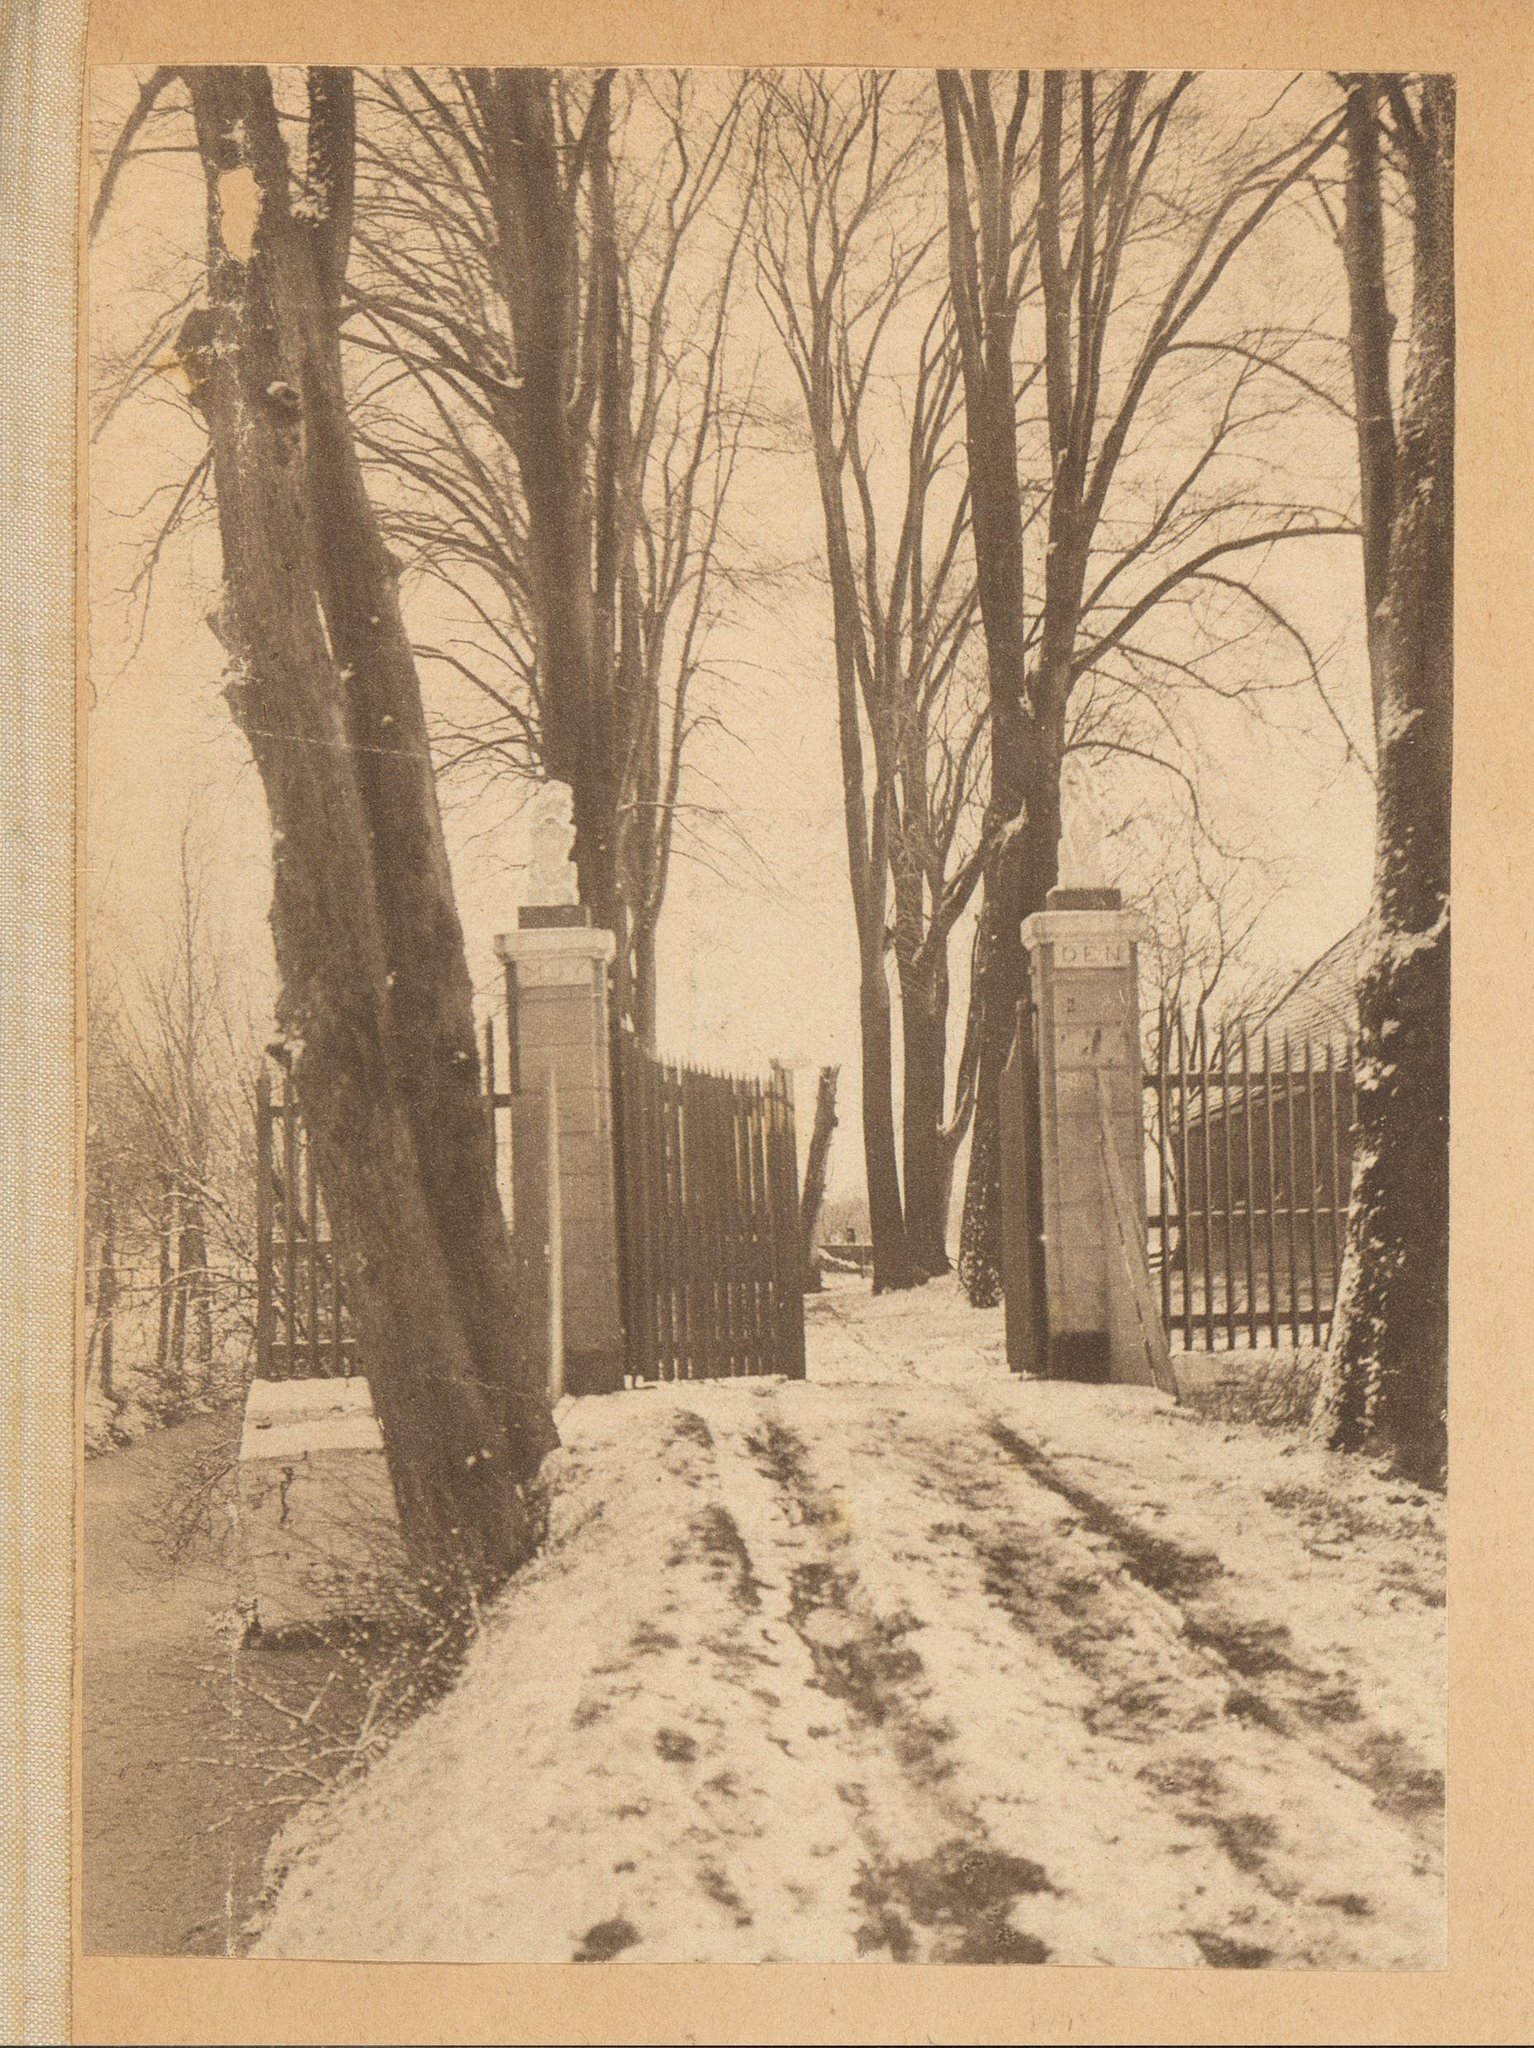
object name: photograph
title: Toegangshek van hoeve Muyden te Rotterdam in de sneeuw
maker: Anonymous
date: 1900-1920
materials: paper, ink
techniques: rotogravure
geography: netherlands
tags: gate, entrance, forest path or lane, snow, rotterdam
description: Toegangshek van hoeve Muyden, gelegen aan het Toepad te Rotterdam. De hoeve is in 1959 gesloopt. Het toegangshek staat tegenwoordig in de tuin van Museum Booijmans van Beuningen in Rotterdam. Onderdeel van Familiealbum met foto's van een familie in de voormalige kolonie Nederlands-Indië en van een suikerfabriek in Purworejo.